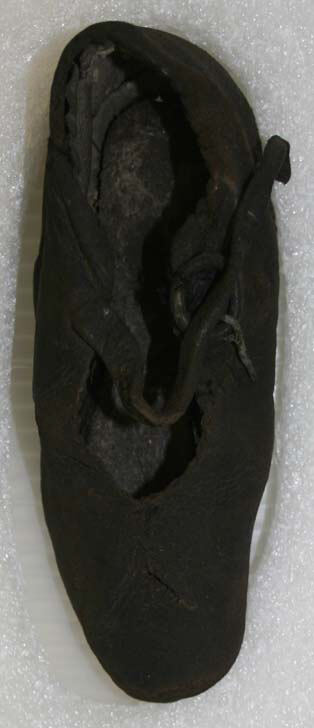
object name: shoe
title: Shoes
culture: british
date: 1601-1700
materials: leather, metal